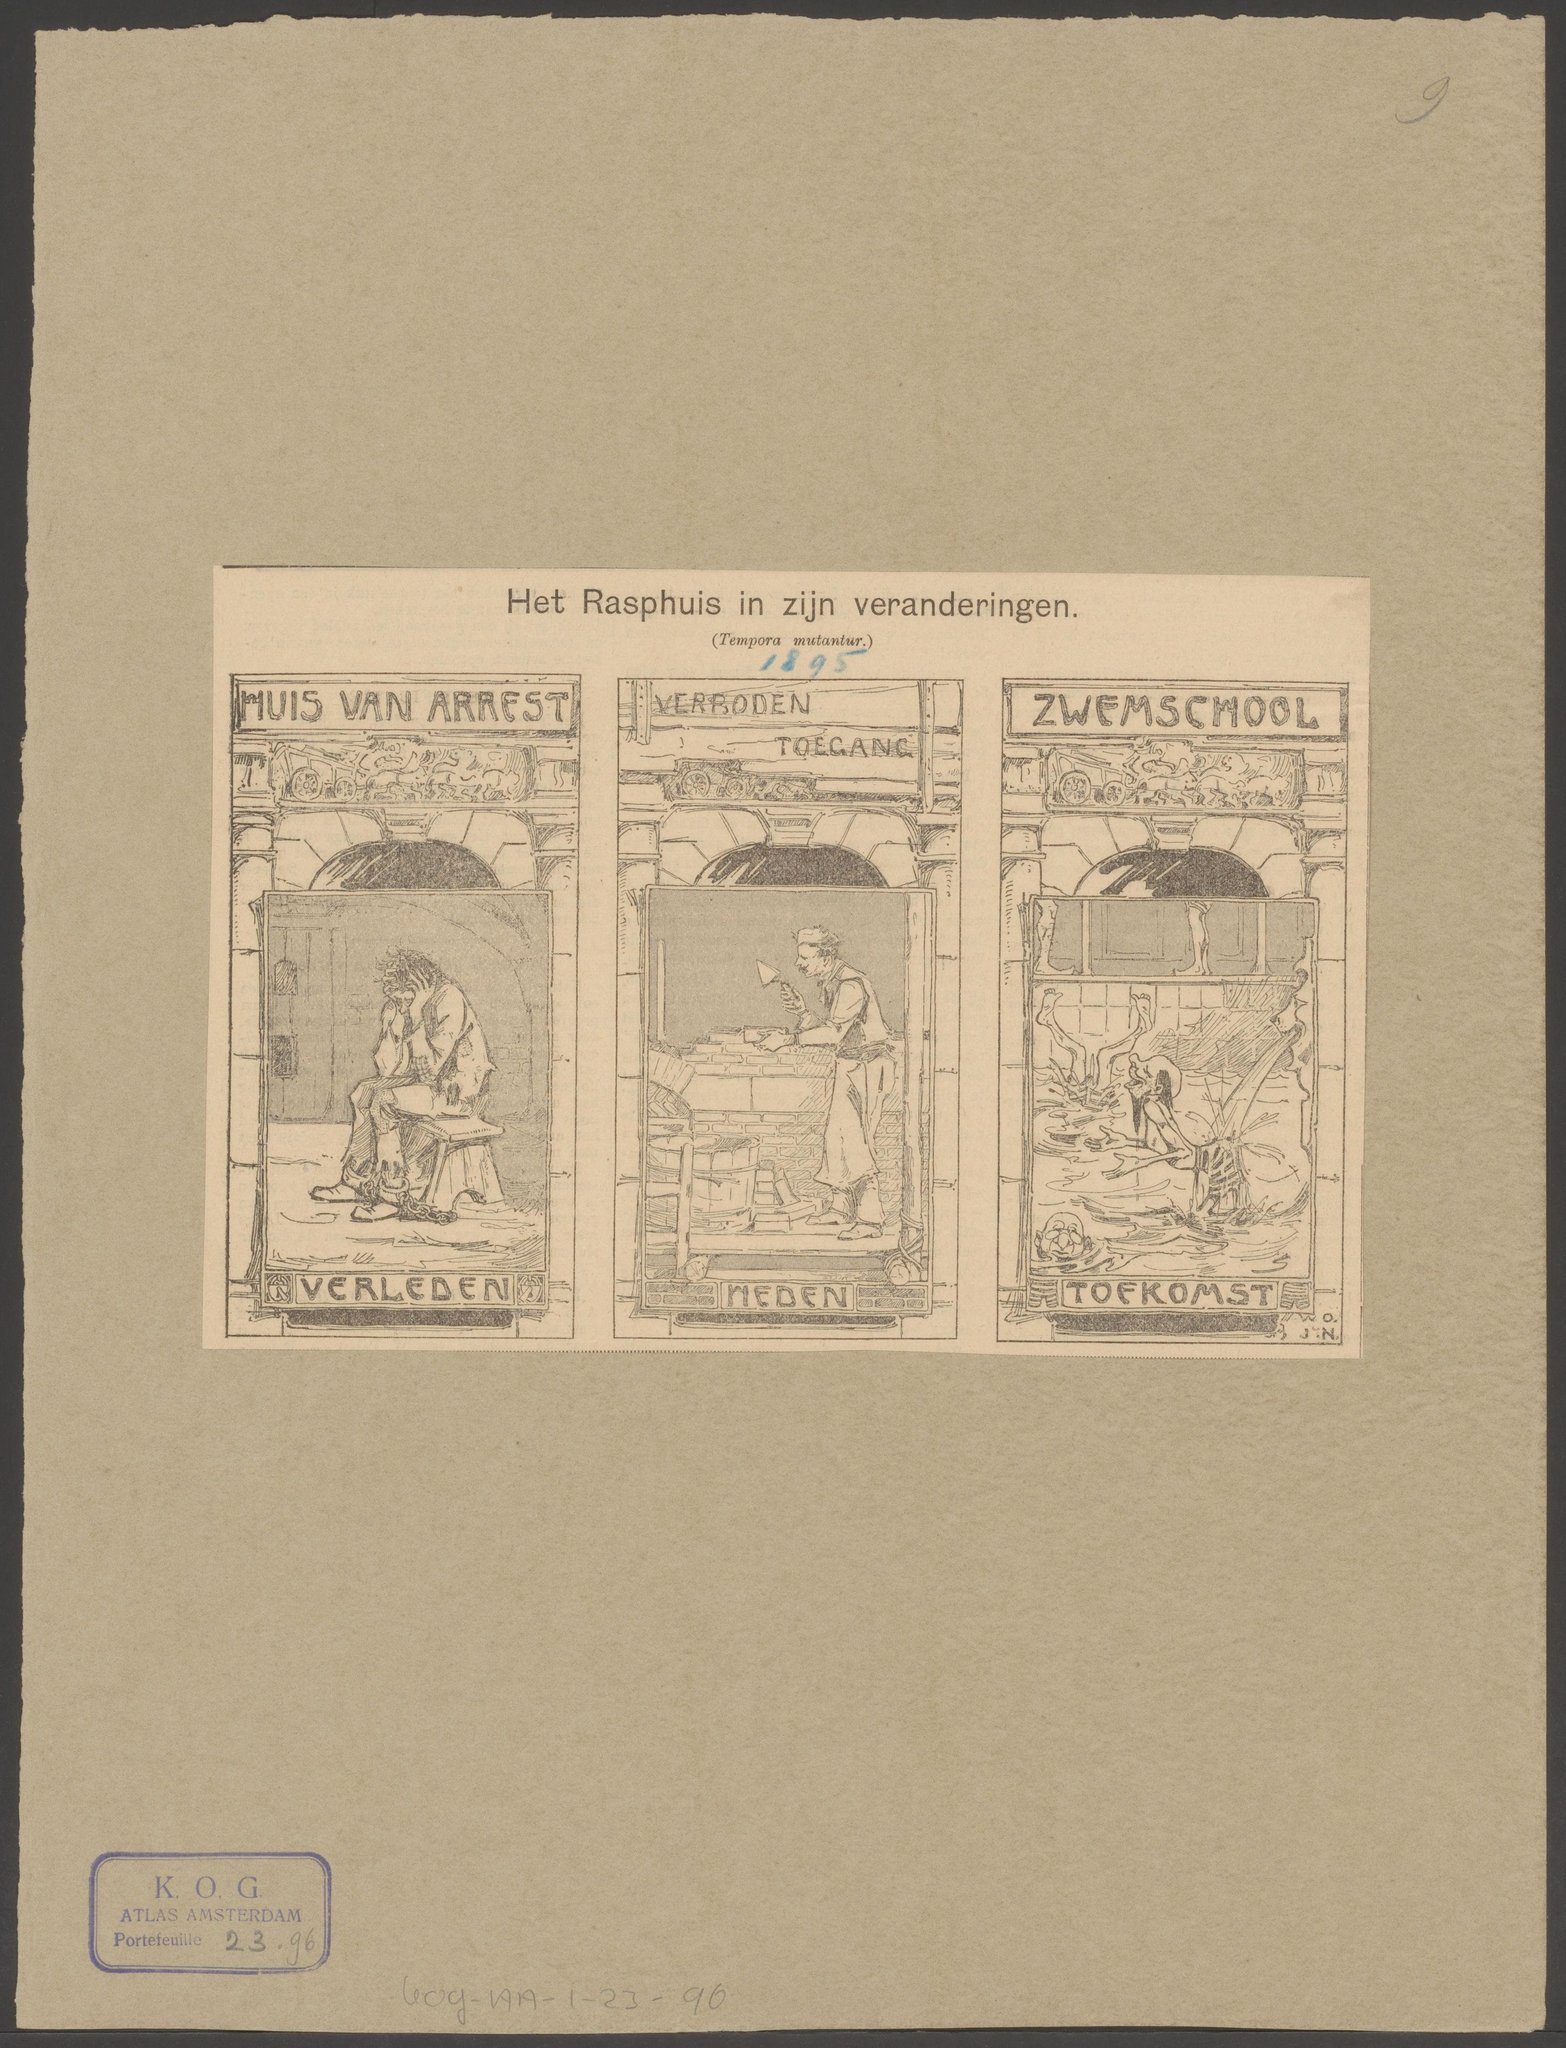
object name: photomechanical print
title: Drie stadia in het bestaan van het Raspuis te Amsterdam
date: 1812-1895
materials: paper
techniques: letterpress printing, line block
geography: netherlands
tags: prison, jail, swimming (sport), mason at work, workhouse, penal camp, penitentiary, chain gang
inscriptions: collector's mark: Lugt 1641b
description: Onderwerpsrubriek binnen de Atlas Amsterdam: Rechtswezen.